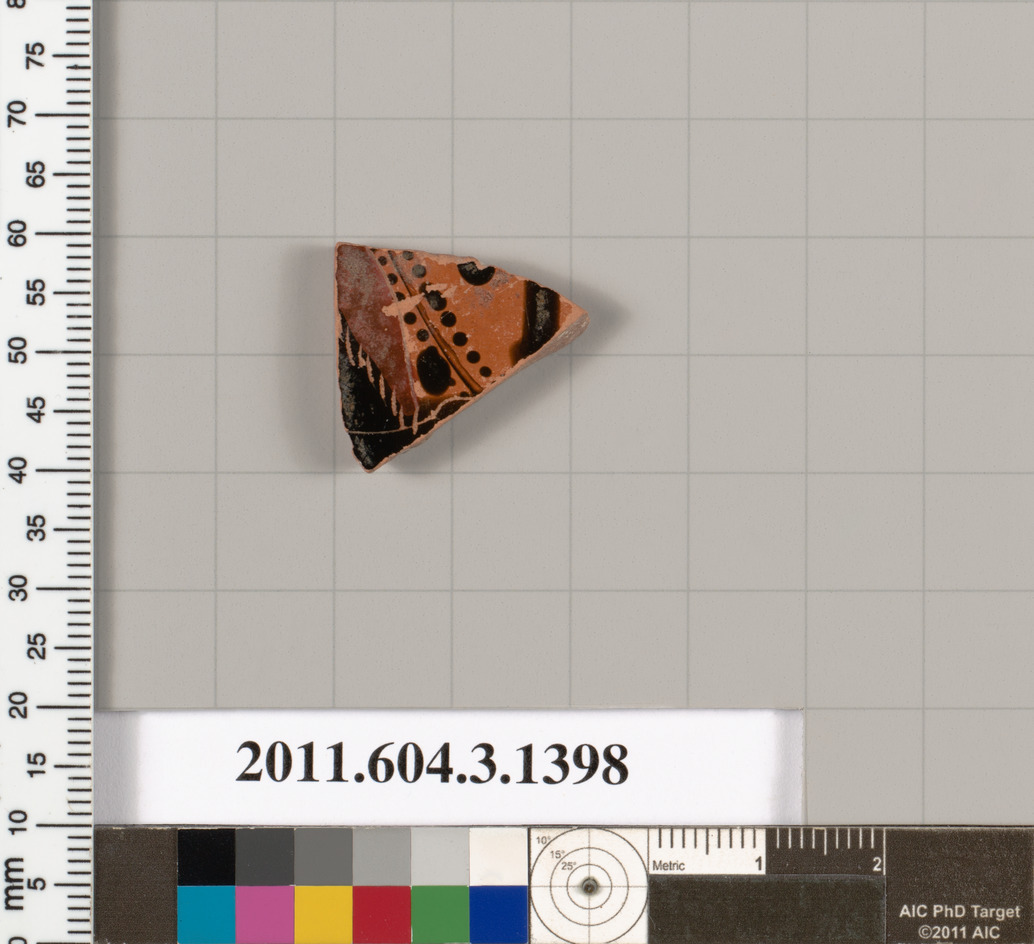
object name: skyphos fragment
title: Terracotta fragment of a skyphos (deep drinking cup)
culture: greek, attic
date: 534-468 BCE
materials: terracotta